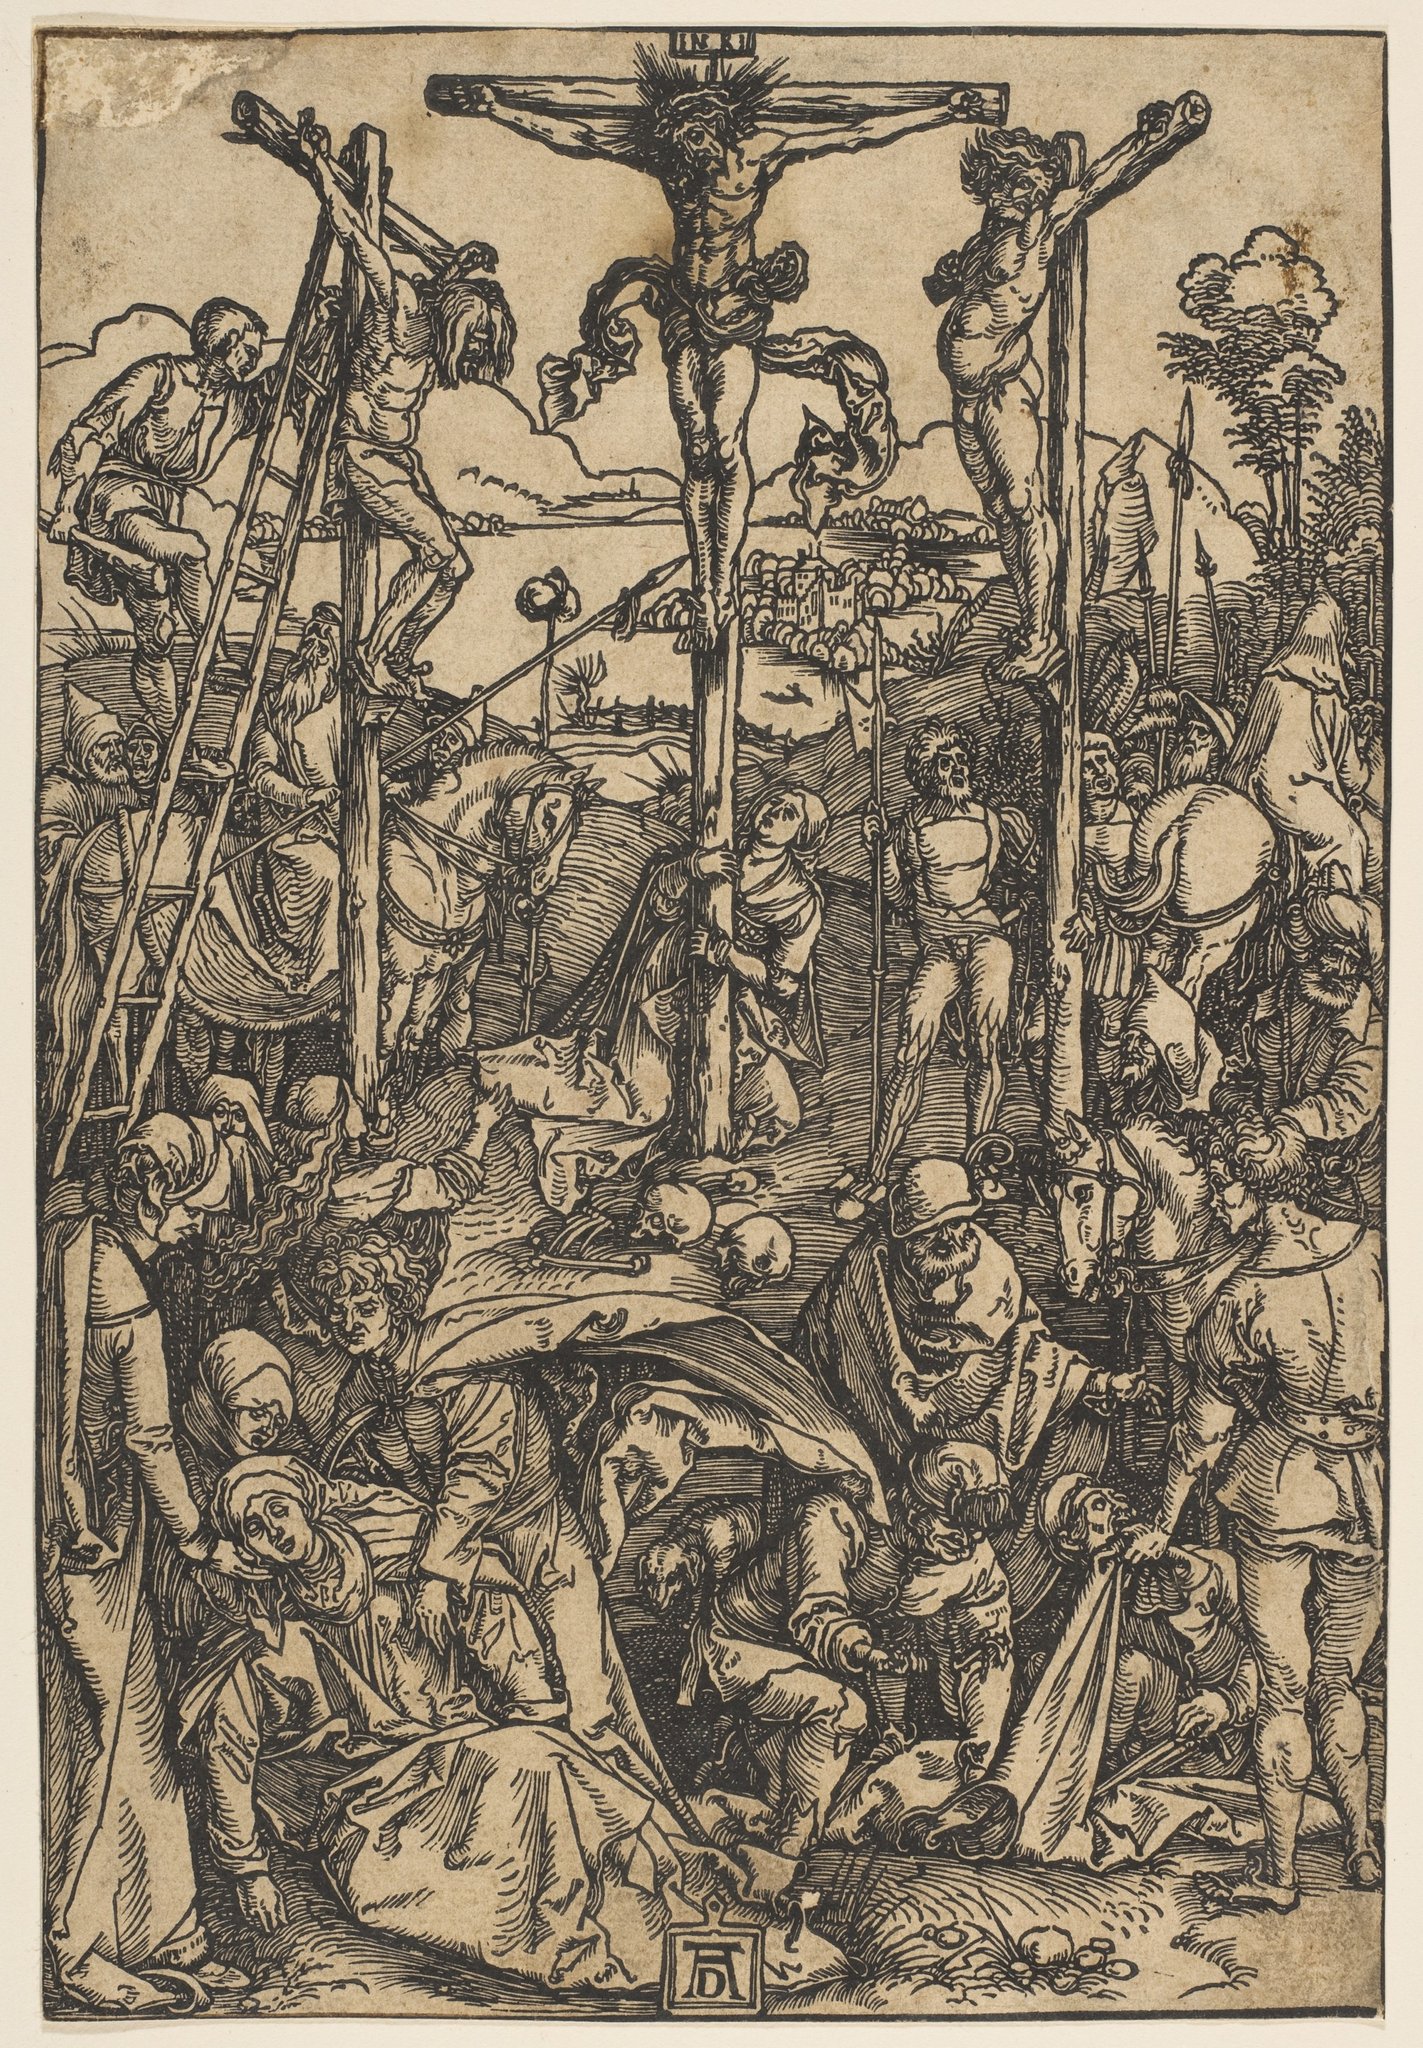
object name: print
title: Calvary with the Three Crosses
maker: albrecht dürer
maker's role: artist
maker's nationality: german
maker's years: 1471-1528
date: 1503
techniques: woodcut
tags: christ,crucifixion